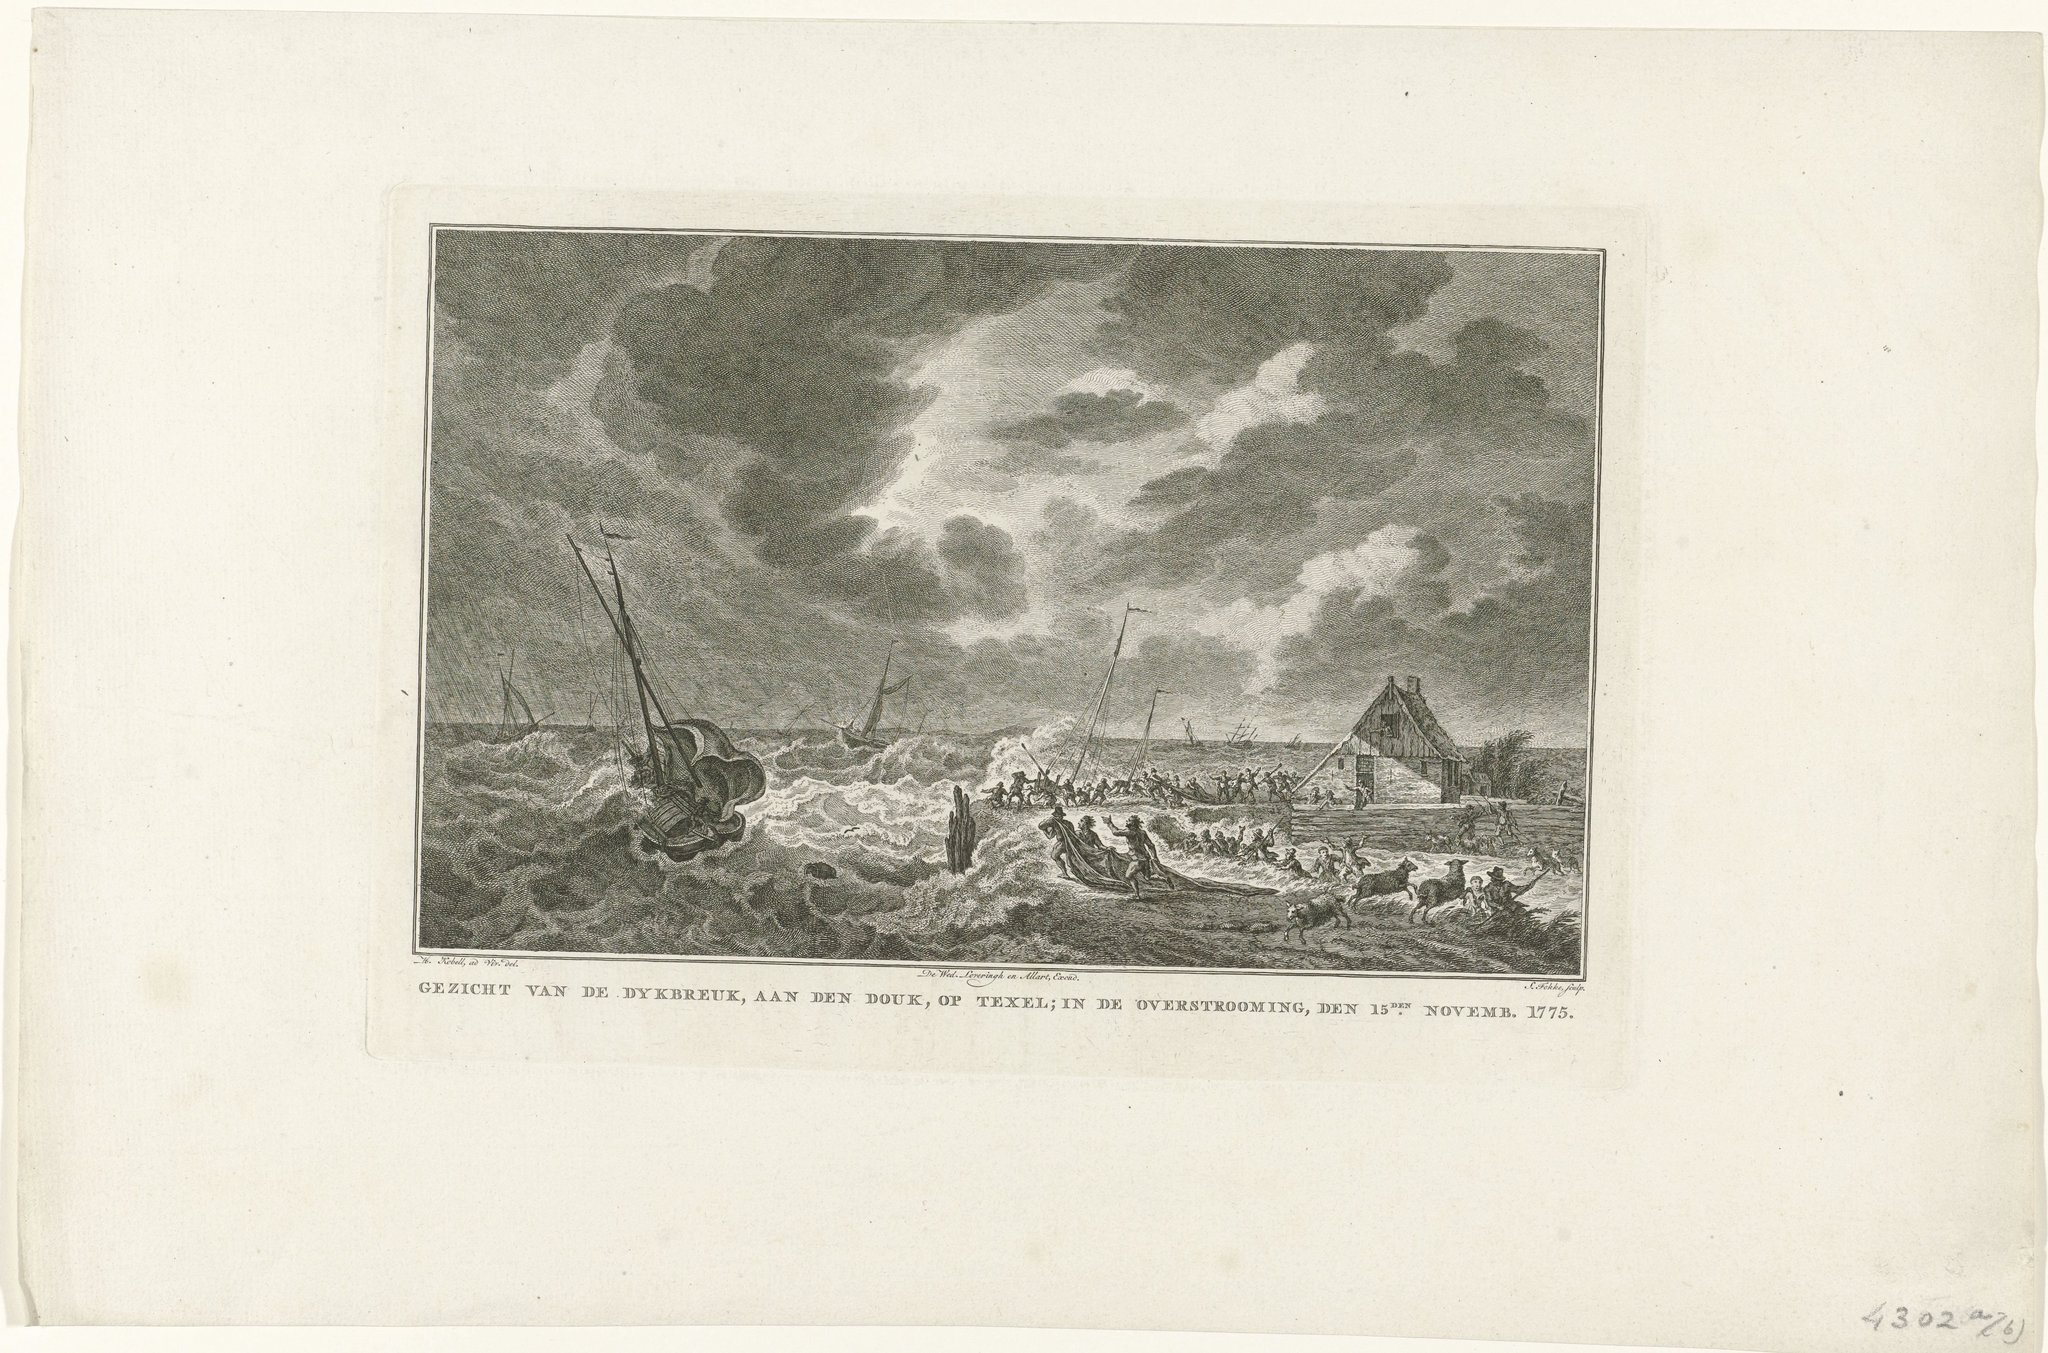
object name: print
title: Dijkdoorbraak op Texel, 1775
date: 1775-1776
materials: paper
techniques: engraving, etching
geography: northern netherlands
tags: dike-break, the flood of 14-18 november 1775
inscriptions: collector's mark: Lugt 2228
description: Prent gebruikt in: Hering, Johan Hendrik. Bespiegeling over Neêrlandsch waternood, tusschen den 14den. en 15den. nov: MDCCLXXV. 2 delen. Amsterdam: weduwe Jacobus Loveringh & Johannes Allart, 1776.